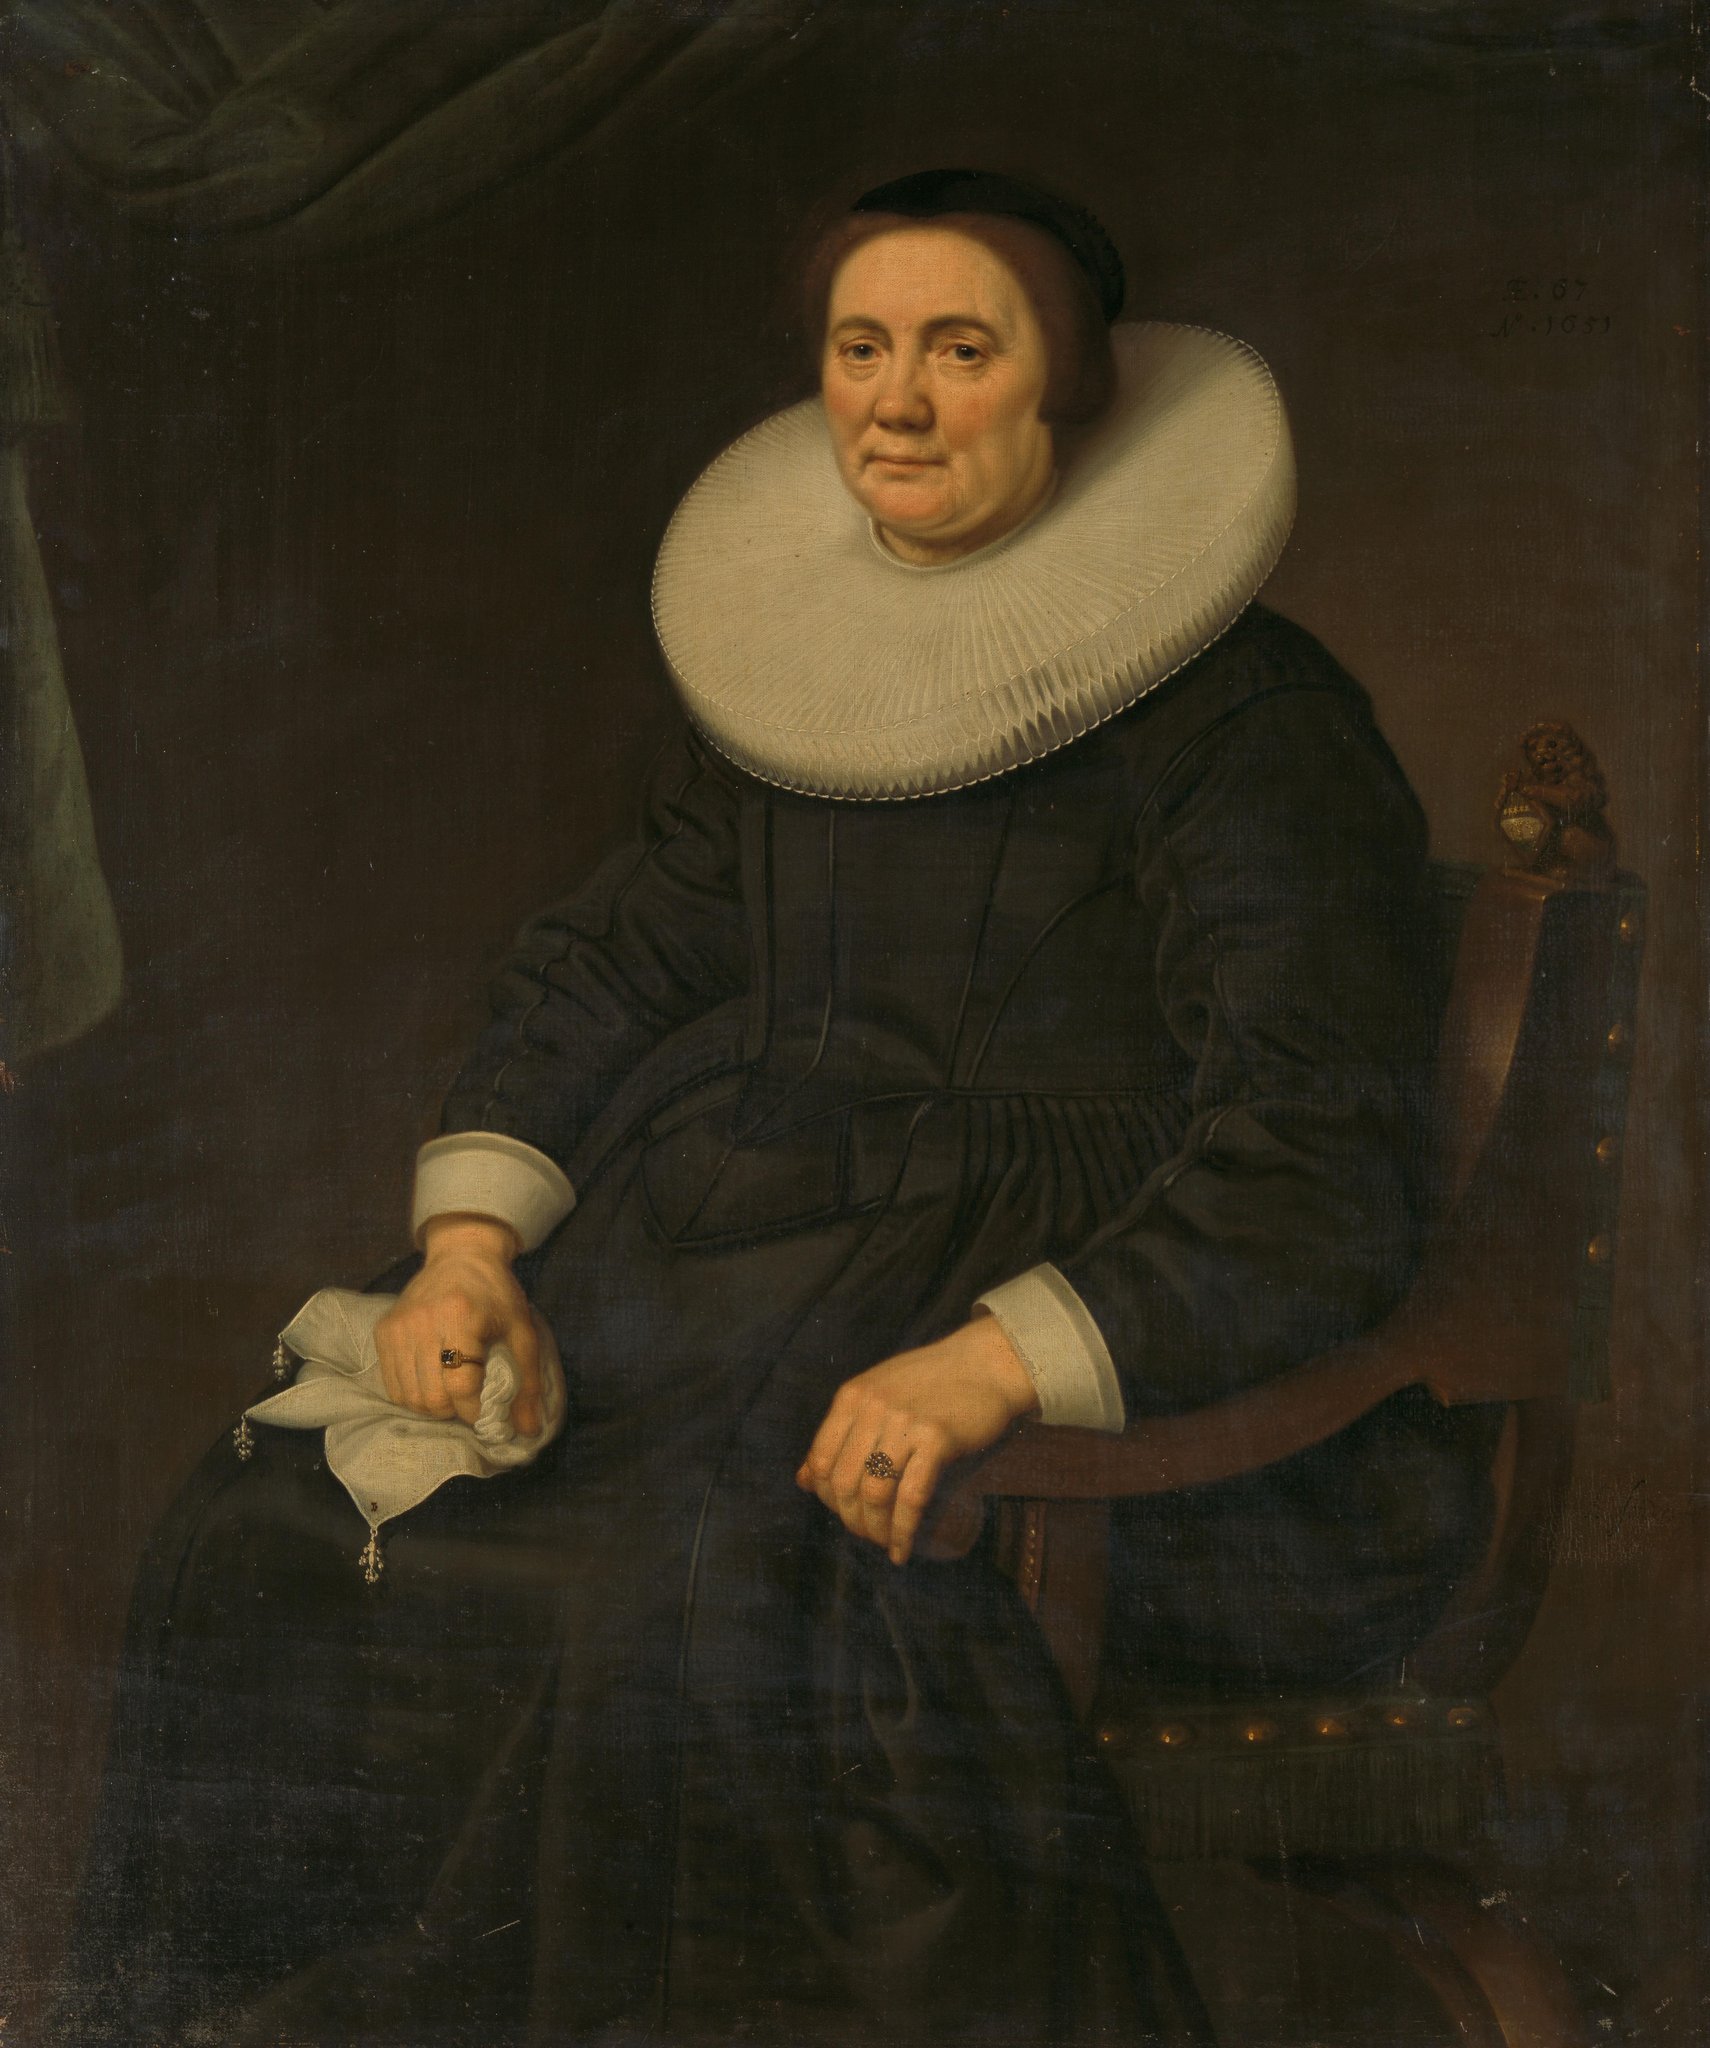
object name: painting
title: Portrait of a woman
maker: hercules sanders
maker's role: painter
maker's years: 1606-1693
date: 1651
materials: canvas, oil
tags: historical persons not known by name - bb - woman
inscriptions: signature: ‘h. sanders fe.t’, inscription and date: ‘AE. 67 A.º 1651’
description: Portret van een vrouw. Kniestuk, zittend in een stoel, een zakdoek in de rechterhand. Op de rug van de stoel een leeuwtje met het familiewapen.